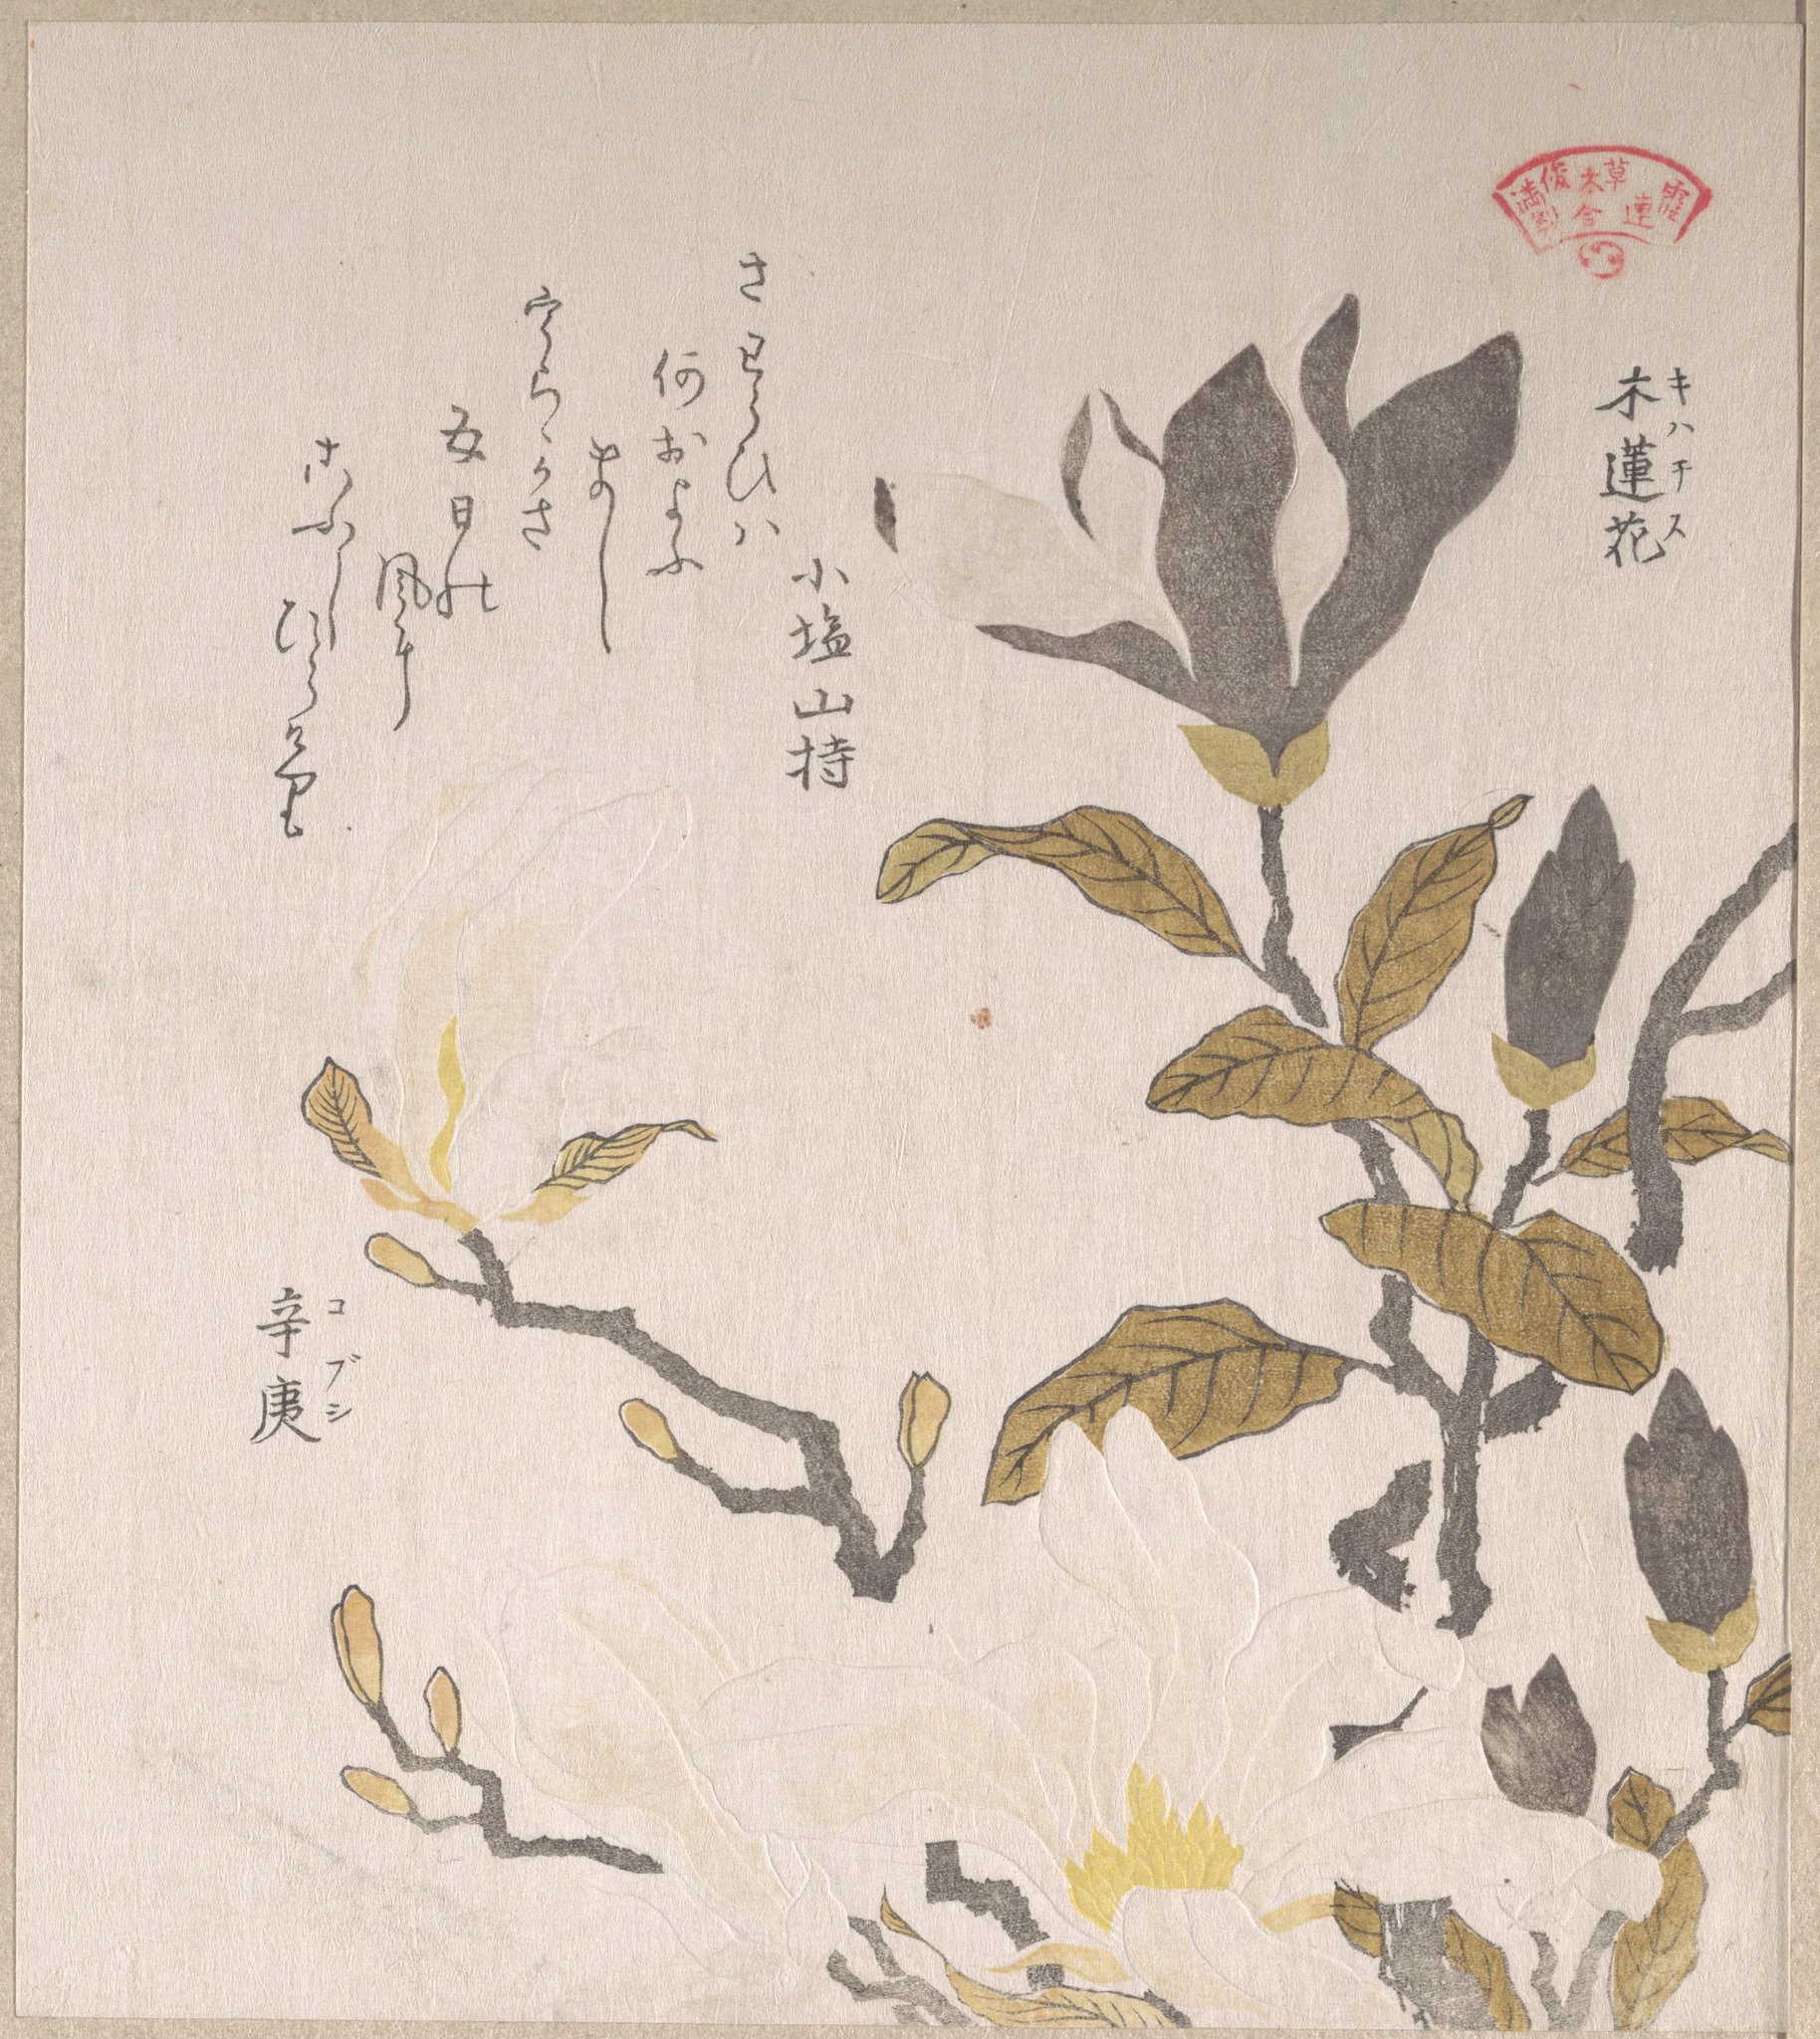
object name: print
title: Magnolia Flowers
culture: japanese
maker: kubo shunman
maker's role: artist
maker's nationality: japanese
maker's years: 1757-1820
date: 1801-1900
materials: ink, paper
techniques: surimono, woodblock print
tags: flowers,leaves